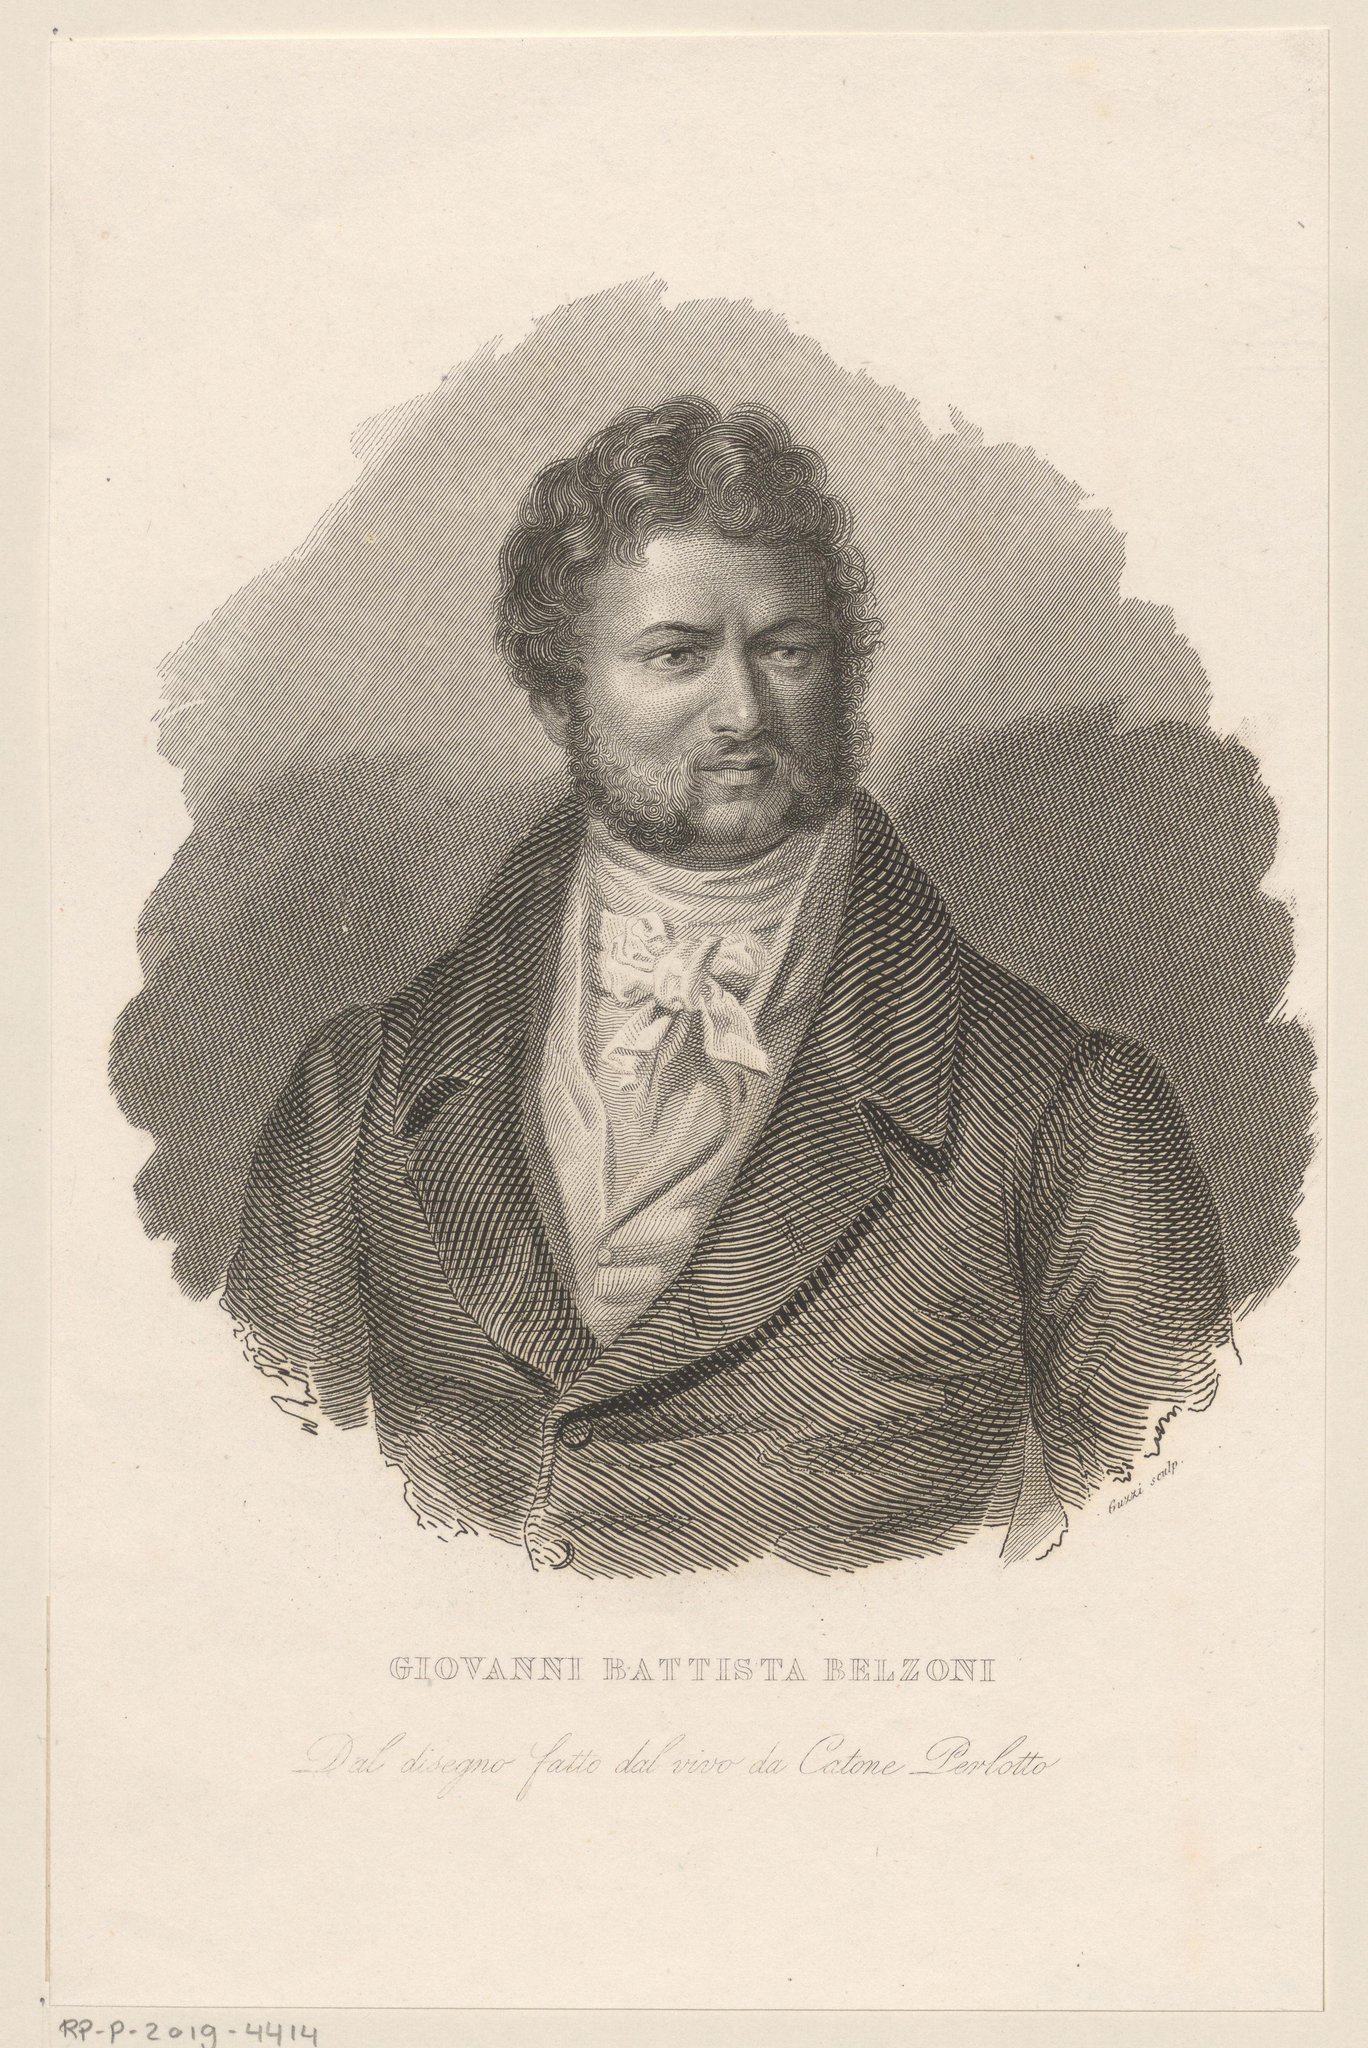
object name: print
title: Portret van Giovanni Battista Belzoni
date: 1834-1842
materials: paper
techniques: engraving, etching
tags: giovanni battista belzoni, historical persons